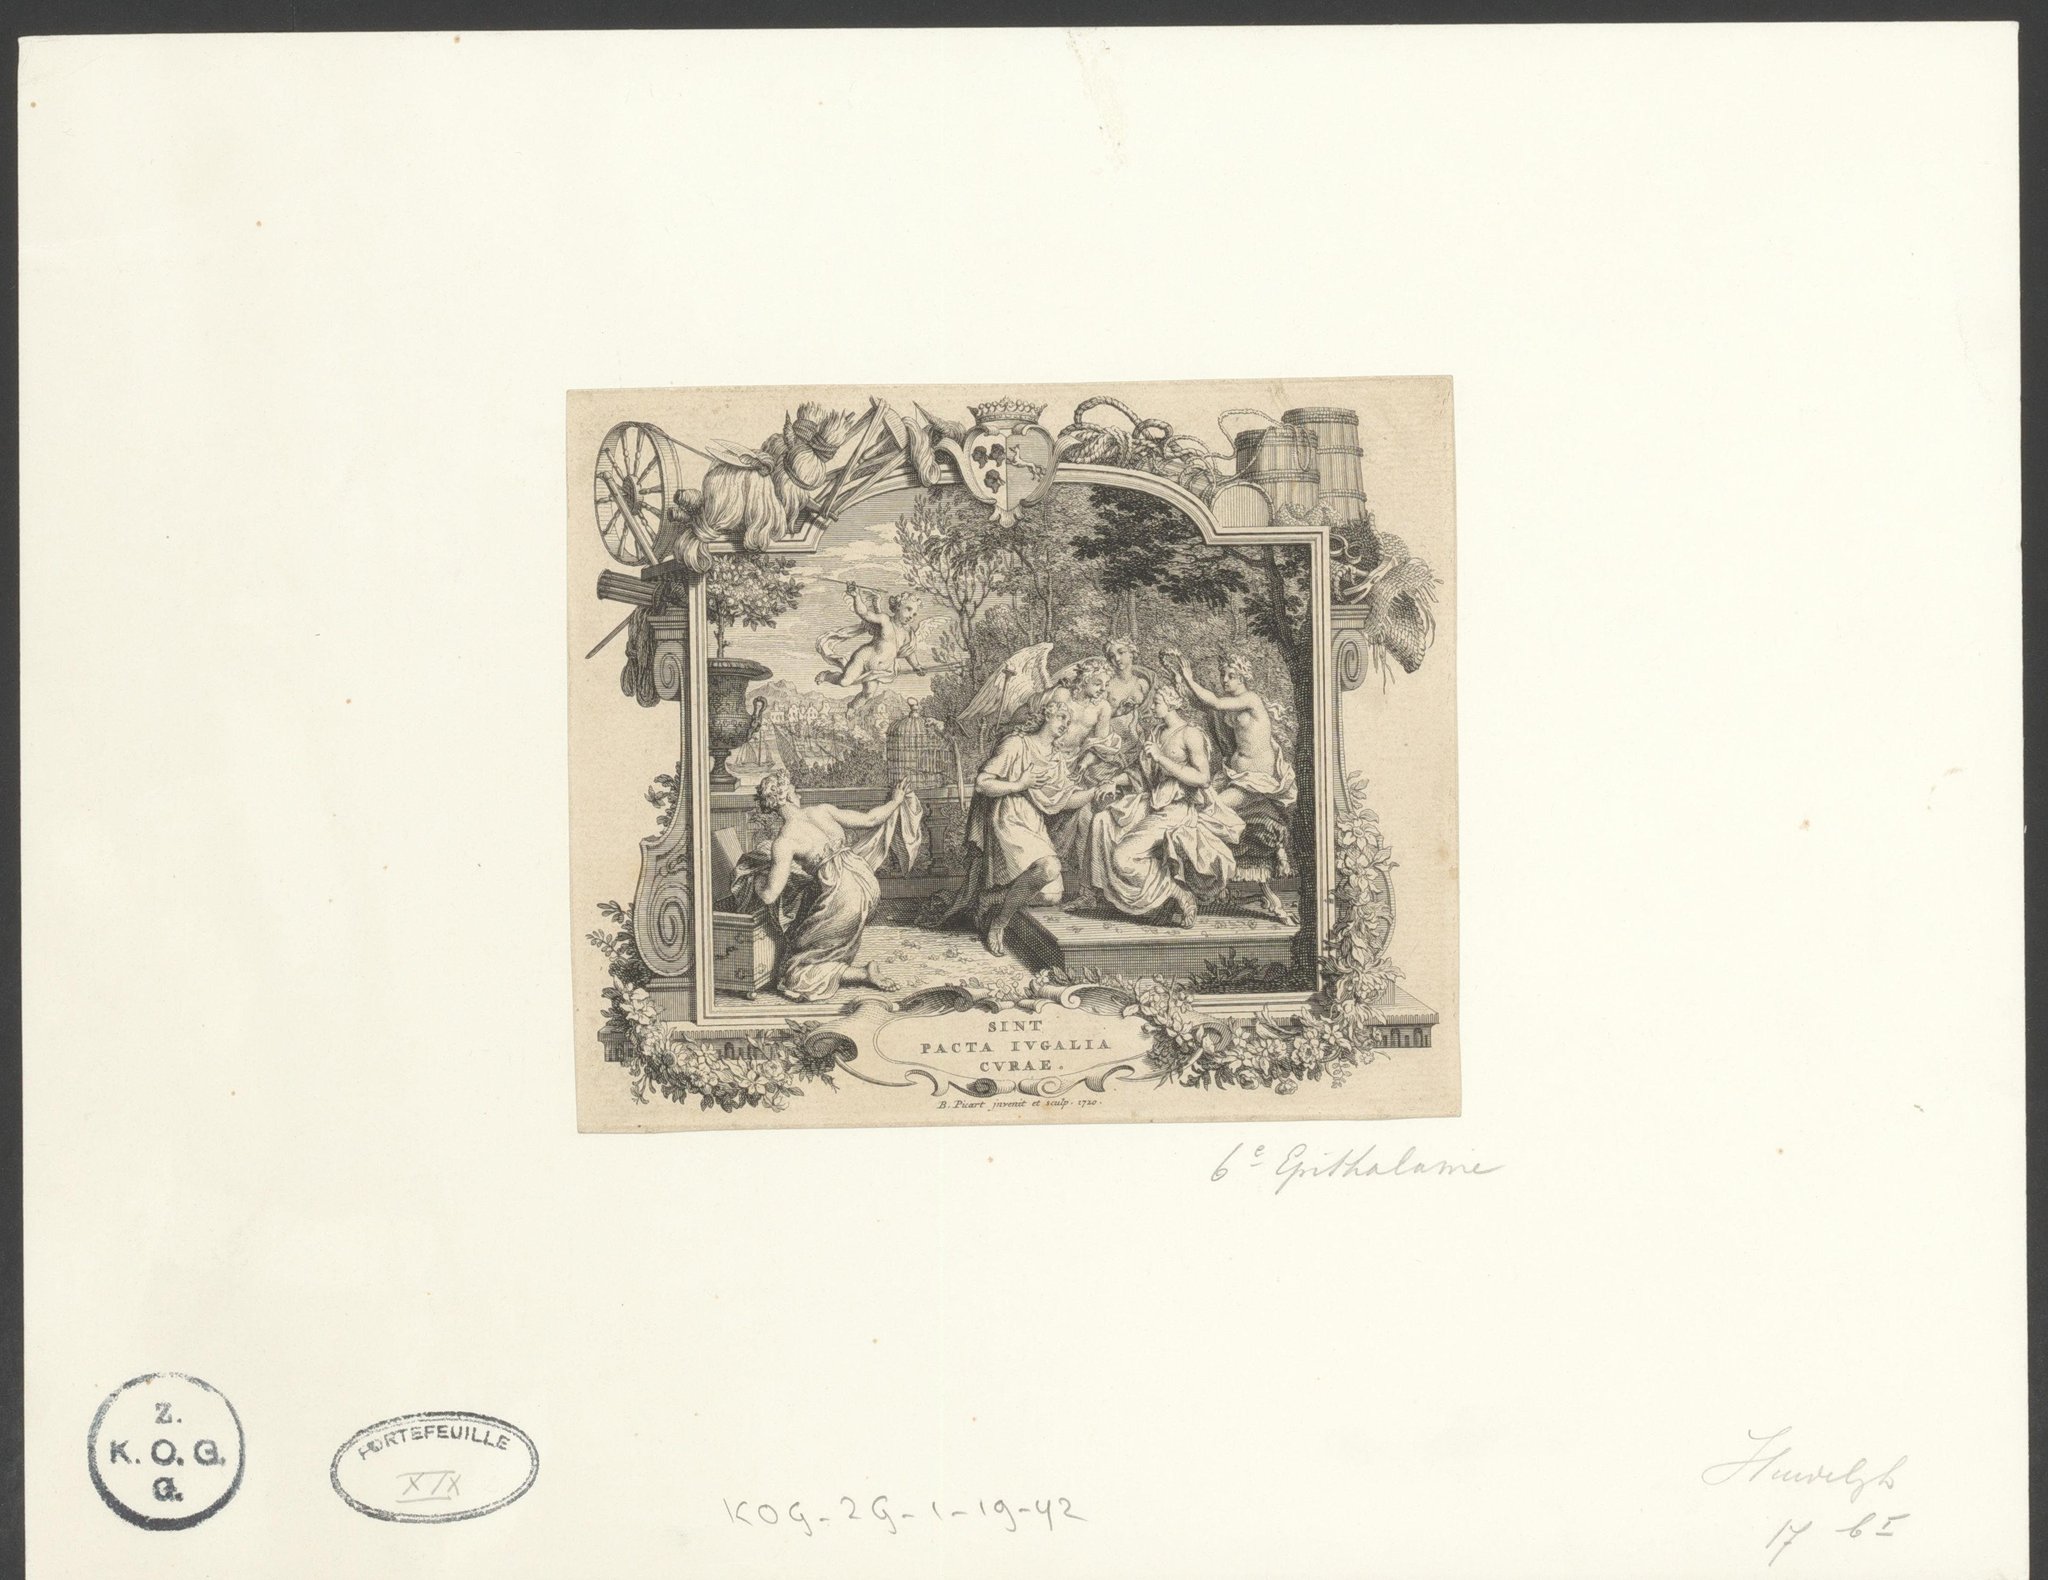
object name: print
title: Bruiloftsprent, 1720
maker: bernard picart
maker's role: draughtsman, print maker, publisher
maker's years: 1673-1733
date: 1720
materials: paper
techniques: engraving, etching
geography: netherlands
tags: (civil) marriage ceremonies, man kneeling before his beloved (proposing)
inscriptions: collector's mark, collector's mark: Lugt 1641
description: Bruiloftsprent uit 1720 met een allegorische voorstelling van een huwelijksaanzoek. Bovenaan het alliantiewapen en symbolen van weverij en houten tonnen en touwen. Onderaan de spreuk 'Sint pacta ivgalia cvrae'. Onderwerpsrubrieken binnen de Atlas Zeden en Gewoonten: Des Menschen Begin, Midden en Einde. Bruiloft en huwelijk.